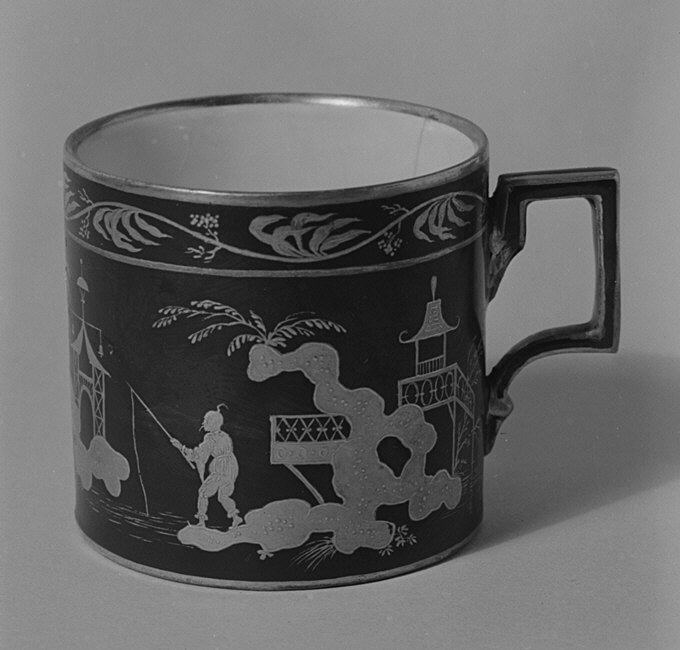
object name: cup and saucer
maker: imperial porcelain manufactory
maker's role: manufactory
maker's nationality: austrian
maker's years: 1744-1864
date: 1793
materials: hard paste porcelain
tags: chinoiserie,fishing